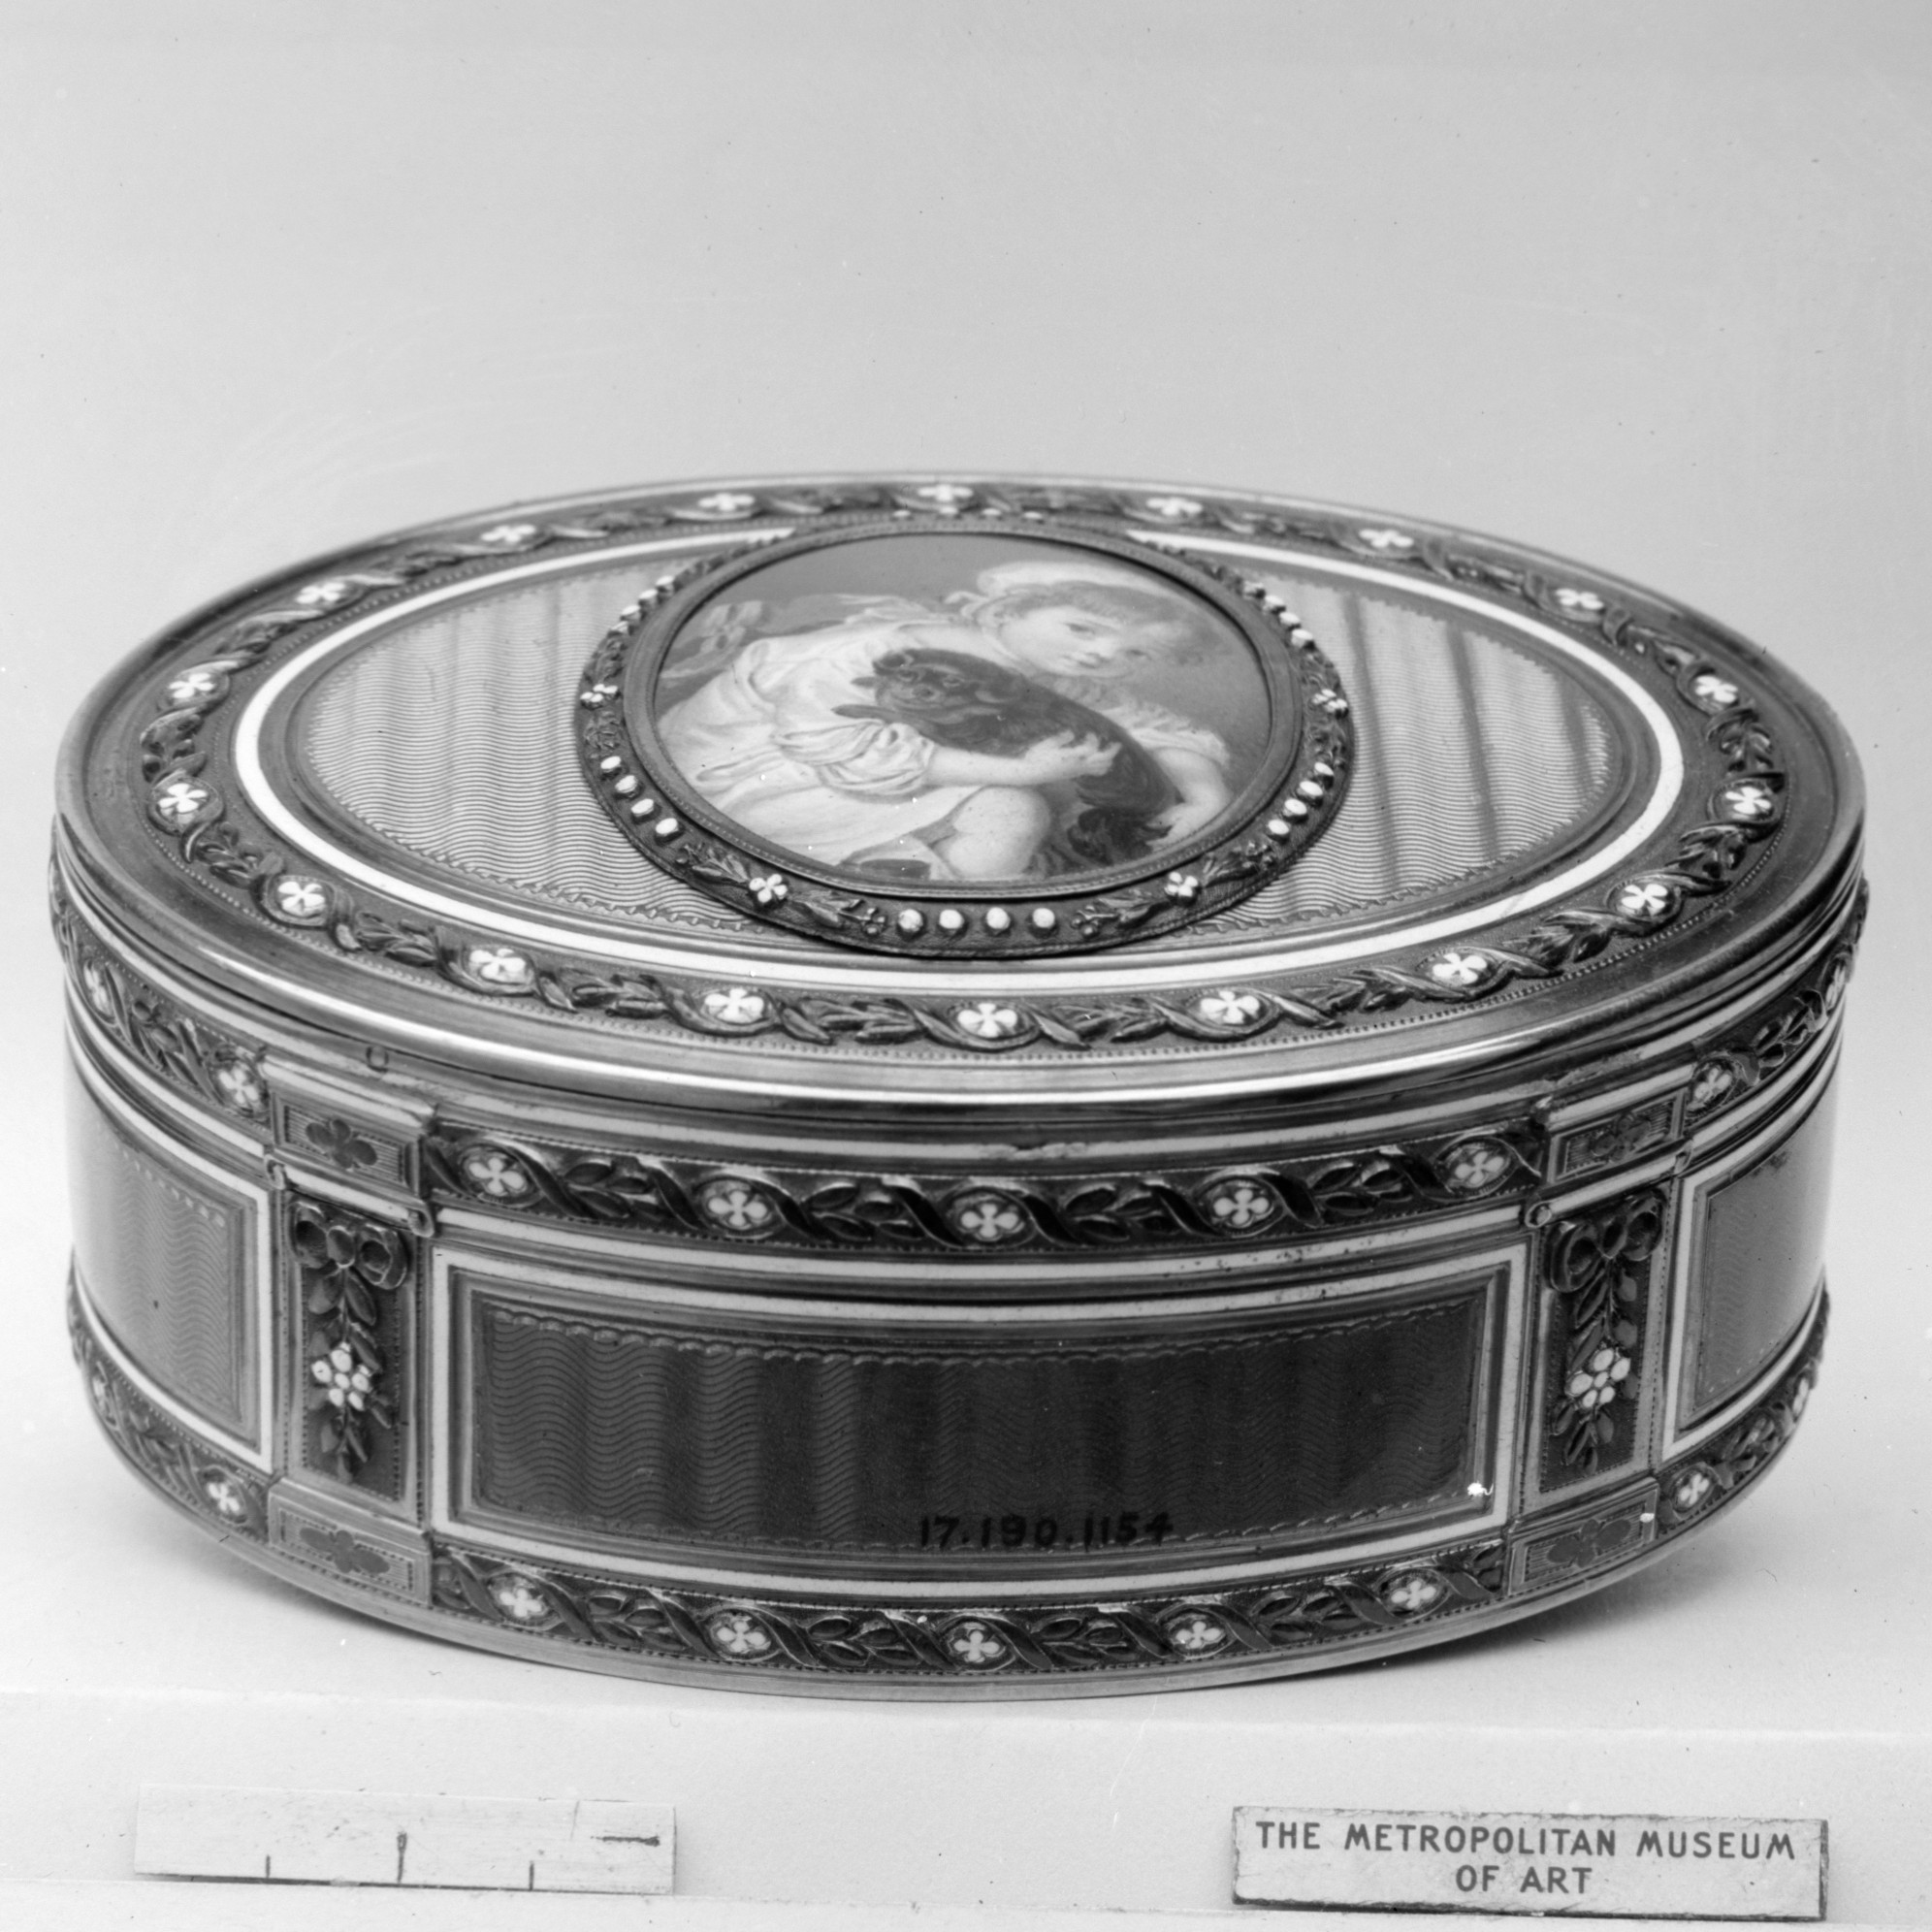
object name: snuffbox, painting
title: Snuffbox with portrait of a child holding a dog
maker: david lhonorey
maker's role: maker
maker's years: 1752-1852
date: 1782-1783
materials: enamel, gold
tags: children,portraits,dogs